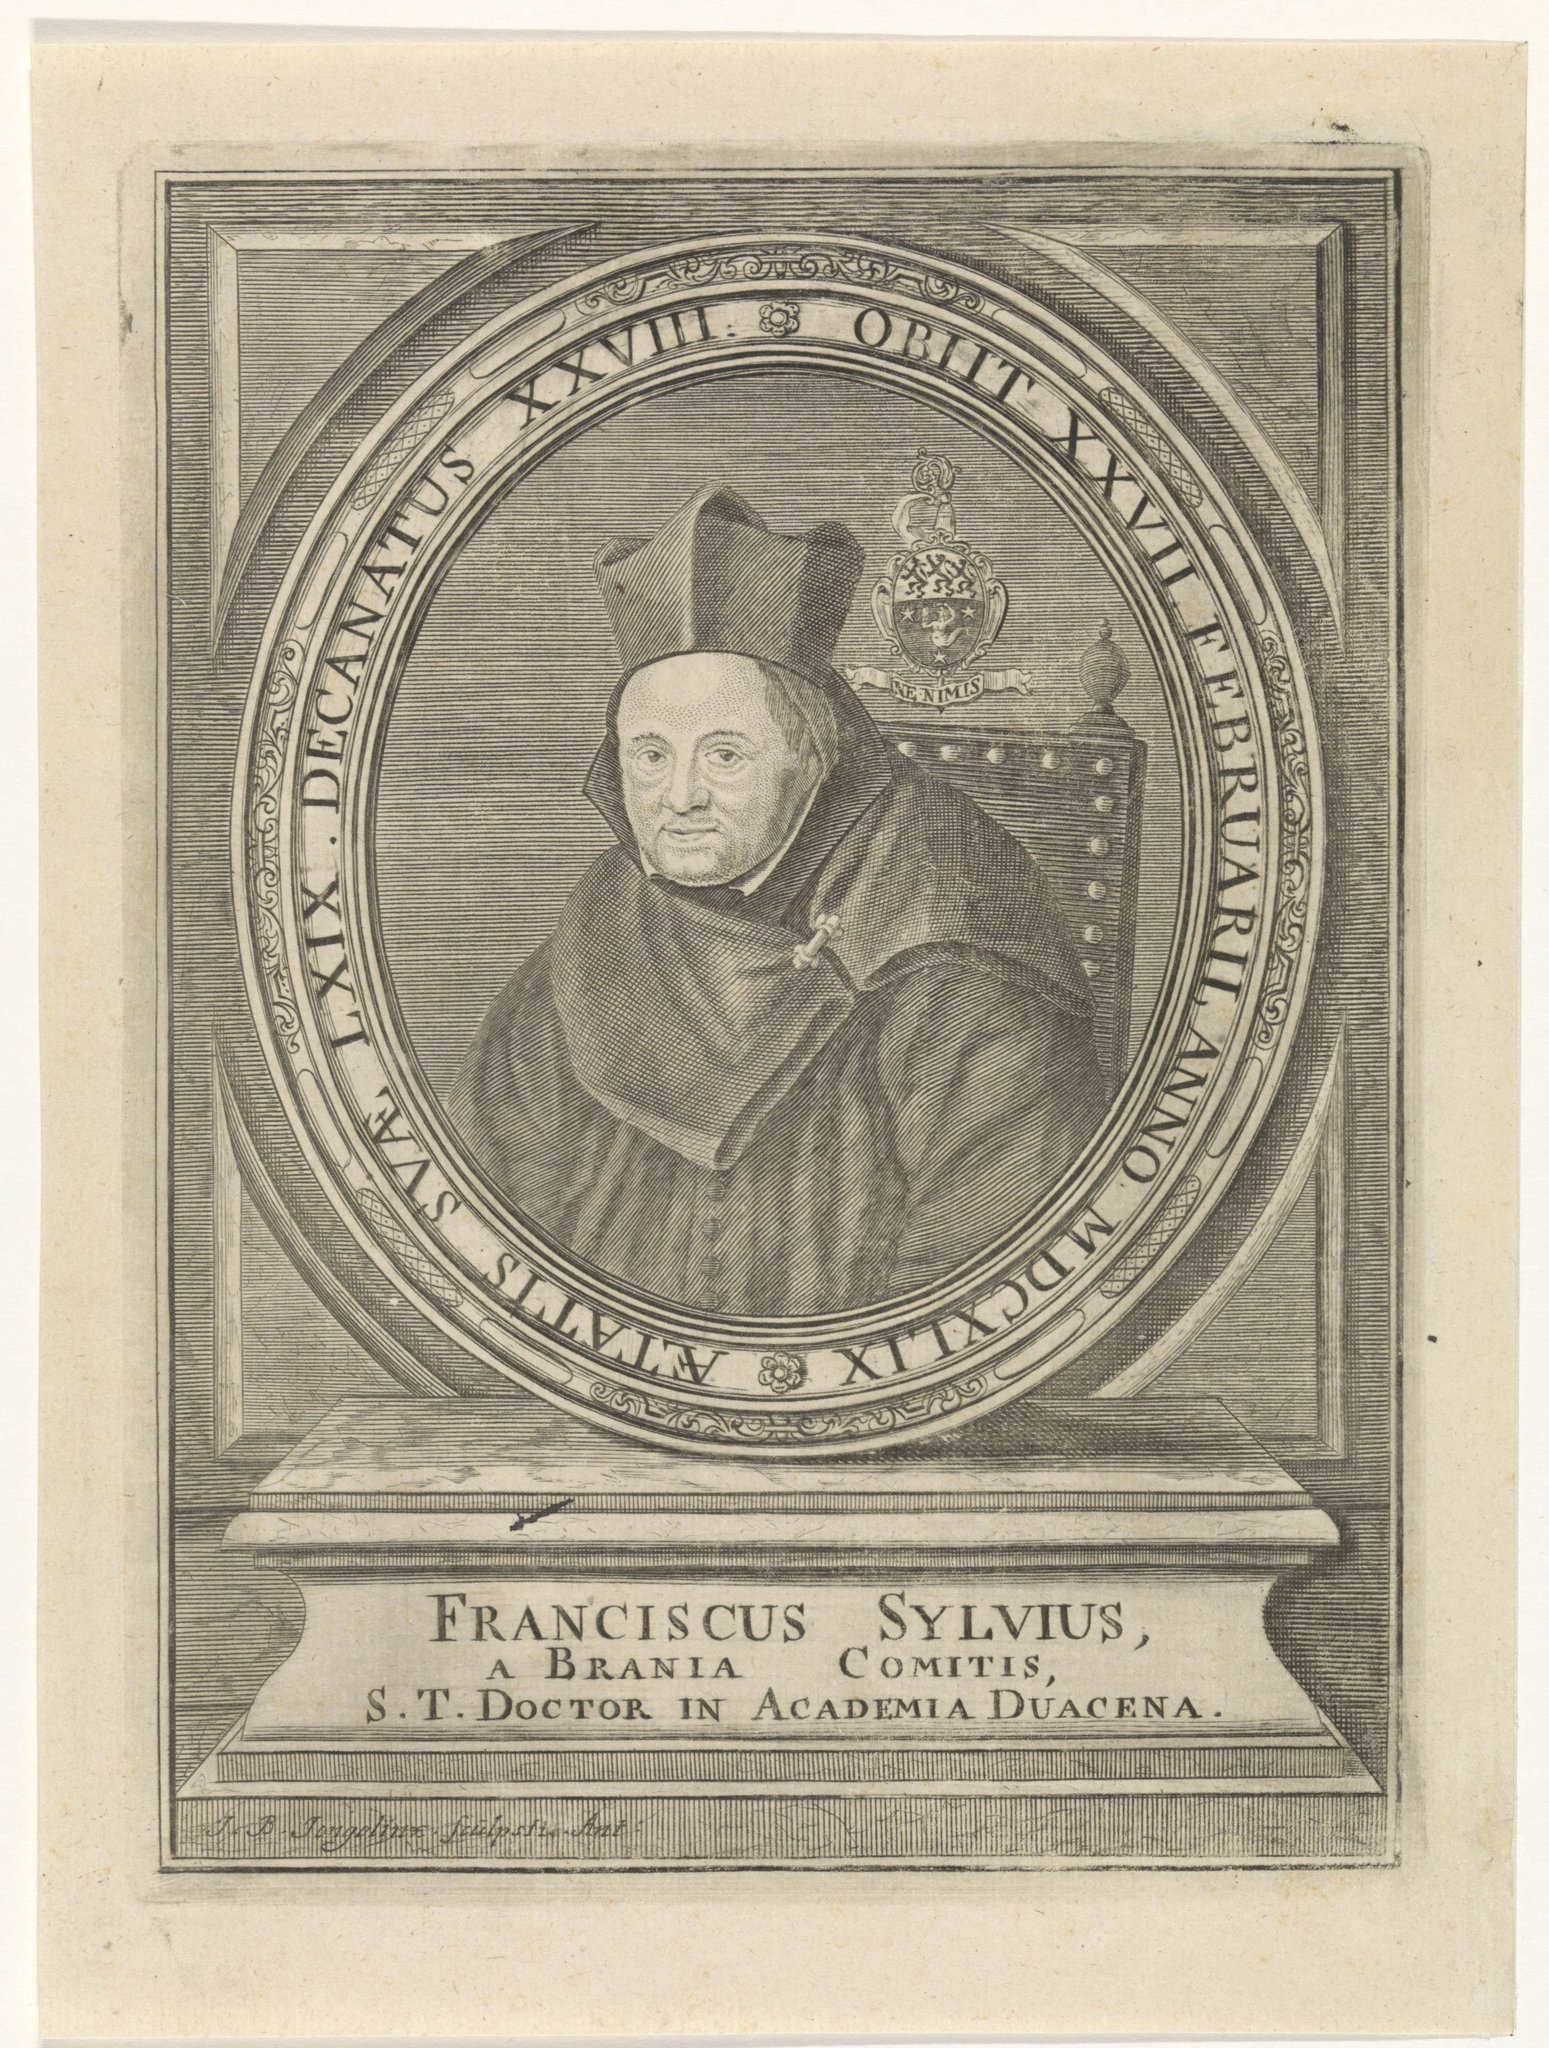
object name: print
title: Portret van Franciscus Sylvius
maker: jan baptist jongelinx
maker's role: print maker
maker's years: 1689-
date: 1710-1725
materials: paper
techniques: engraving, etching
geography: antwerp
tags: theoloog, franciscus sylvius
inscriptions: collector's mark: Lugt 2228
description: Busteportret van de theoloog en professor Franciscus Sylvius, met biretta. Hij zit op een stoel. Naast hem zijn wapenschild met een motto in het Latijn. Het portret is gevat in een ovale omlijsting met vierkant randwerk en een randschrift in het Latijn. Op de piëdestal een drieregelig onderschrift in het Latijn.